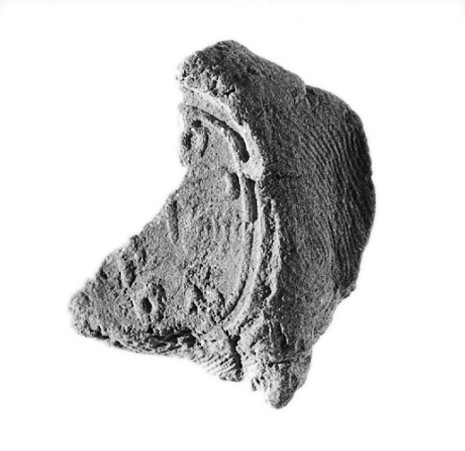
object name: sealing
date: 1981-1640 BCE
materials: mud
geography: egypt